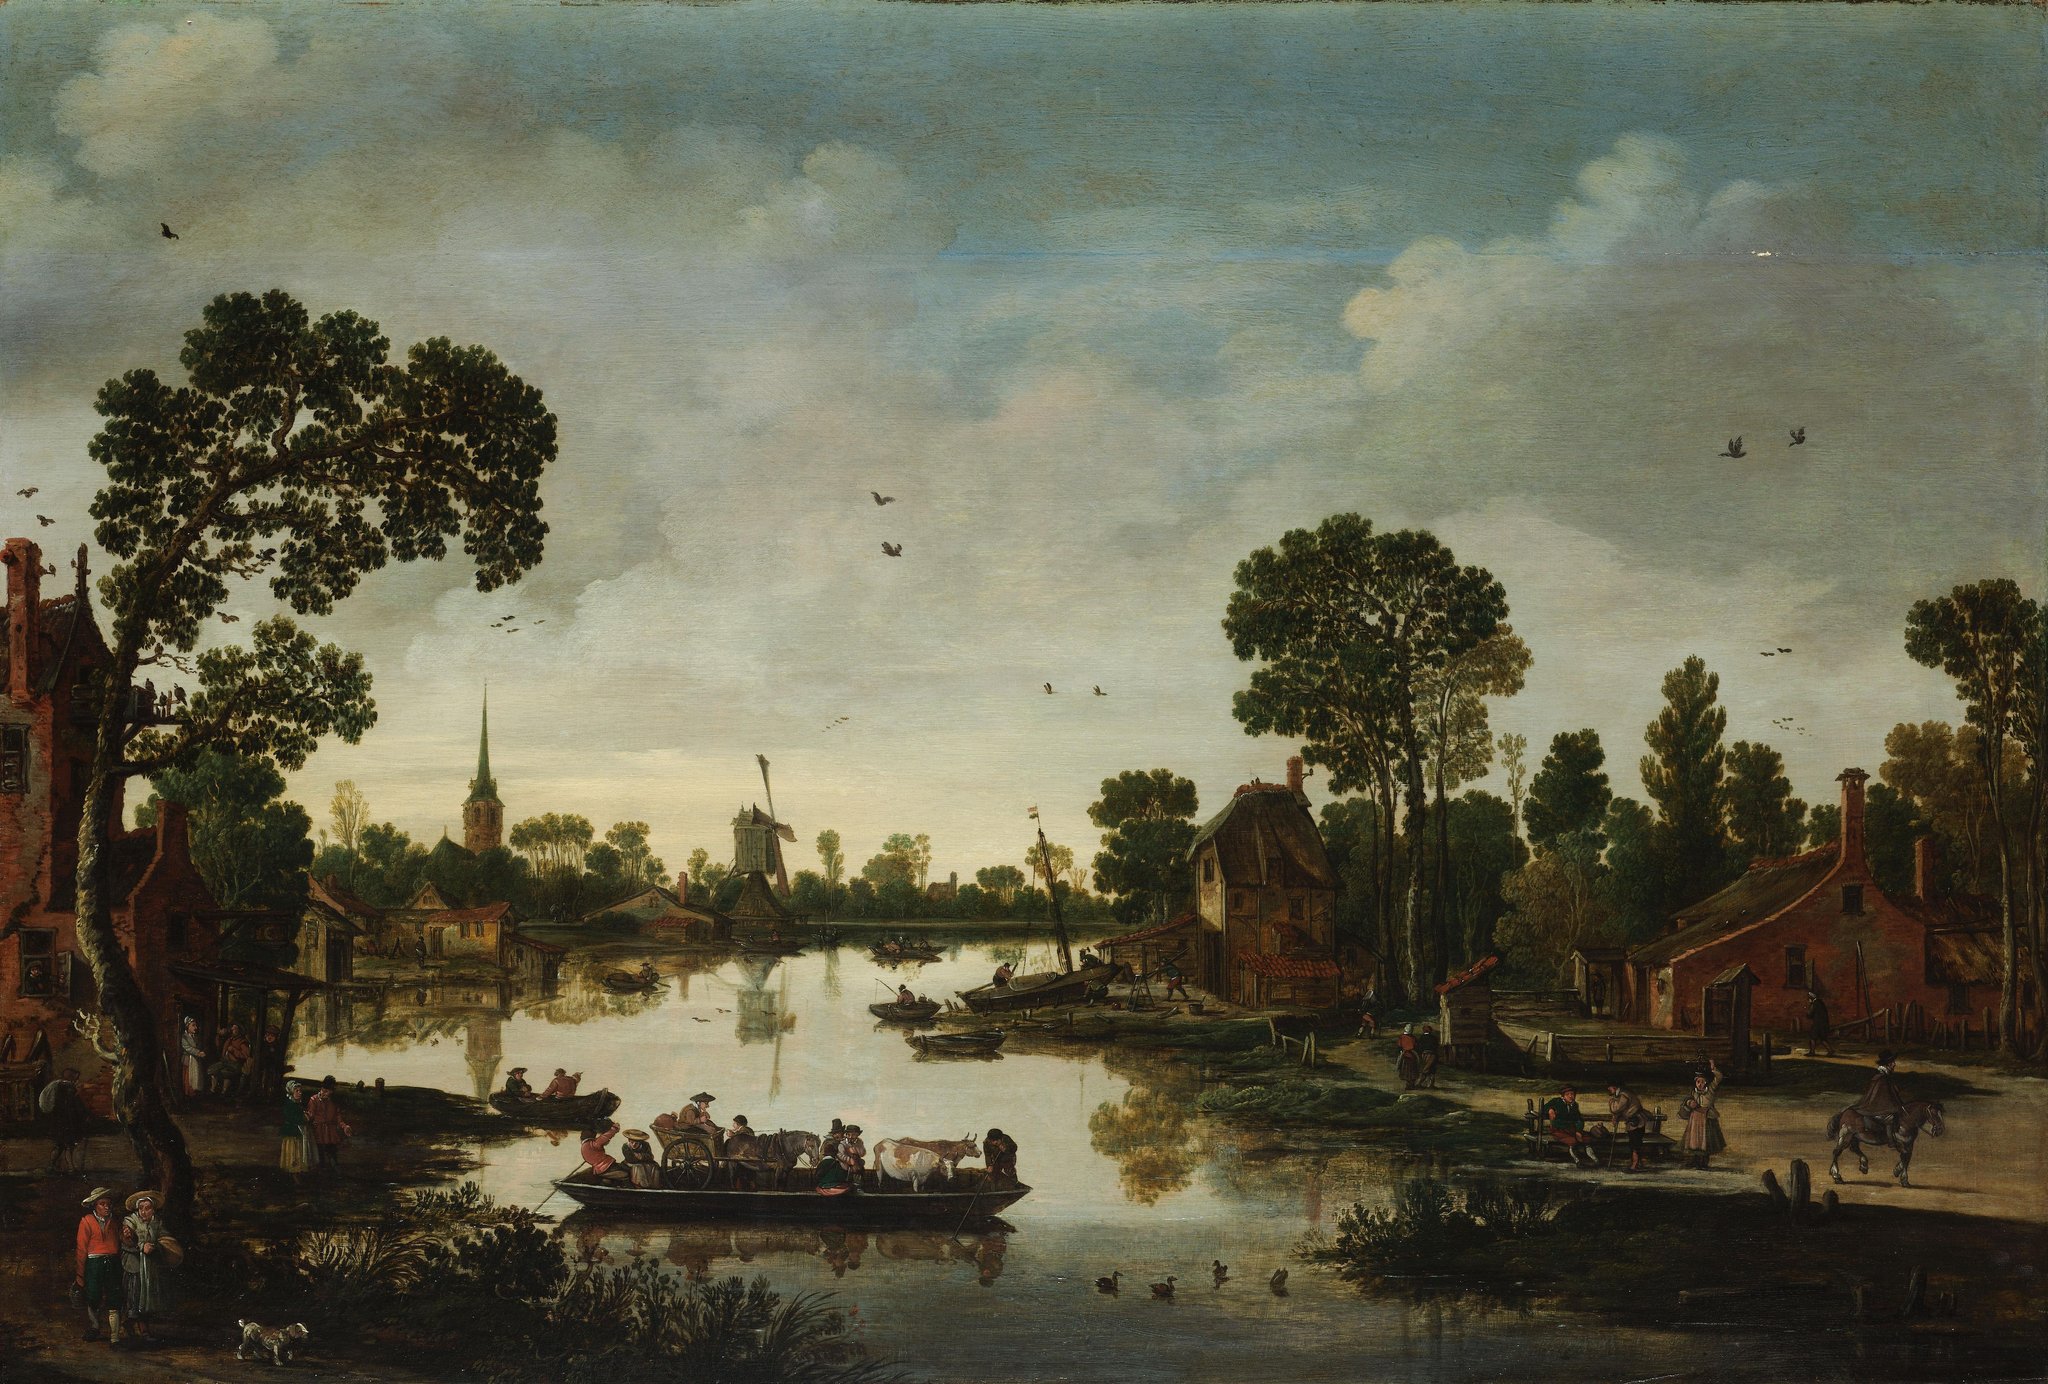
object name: painting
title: The Cattle Ferry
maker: esaias van de velde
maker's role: draughtsman, painter, print maker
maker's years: 1587-1630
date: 1622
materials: oil, panel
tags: river, ferry, windmill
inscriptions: signature and date, lower right: ‘E. V. VELDE 1622’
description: This painting is a milestone, for never before had a Dutch painter depicted his native flat, watery landscape in such a monumental format. Dusk is falling, and the light is beginning to fade. The glistening river winds its way into the distance, drawing the viewer along, too, past countless little figures.